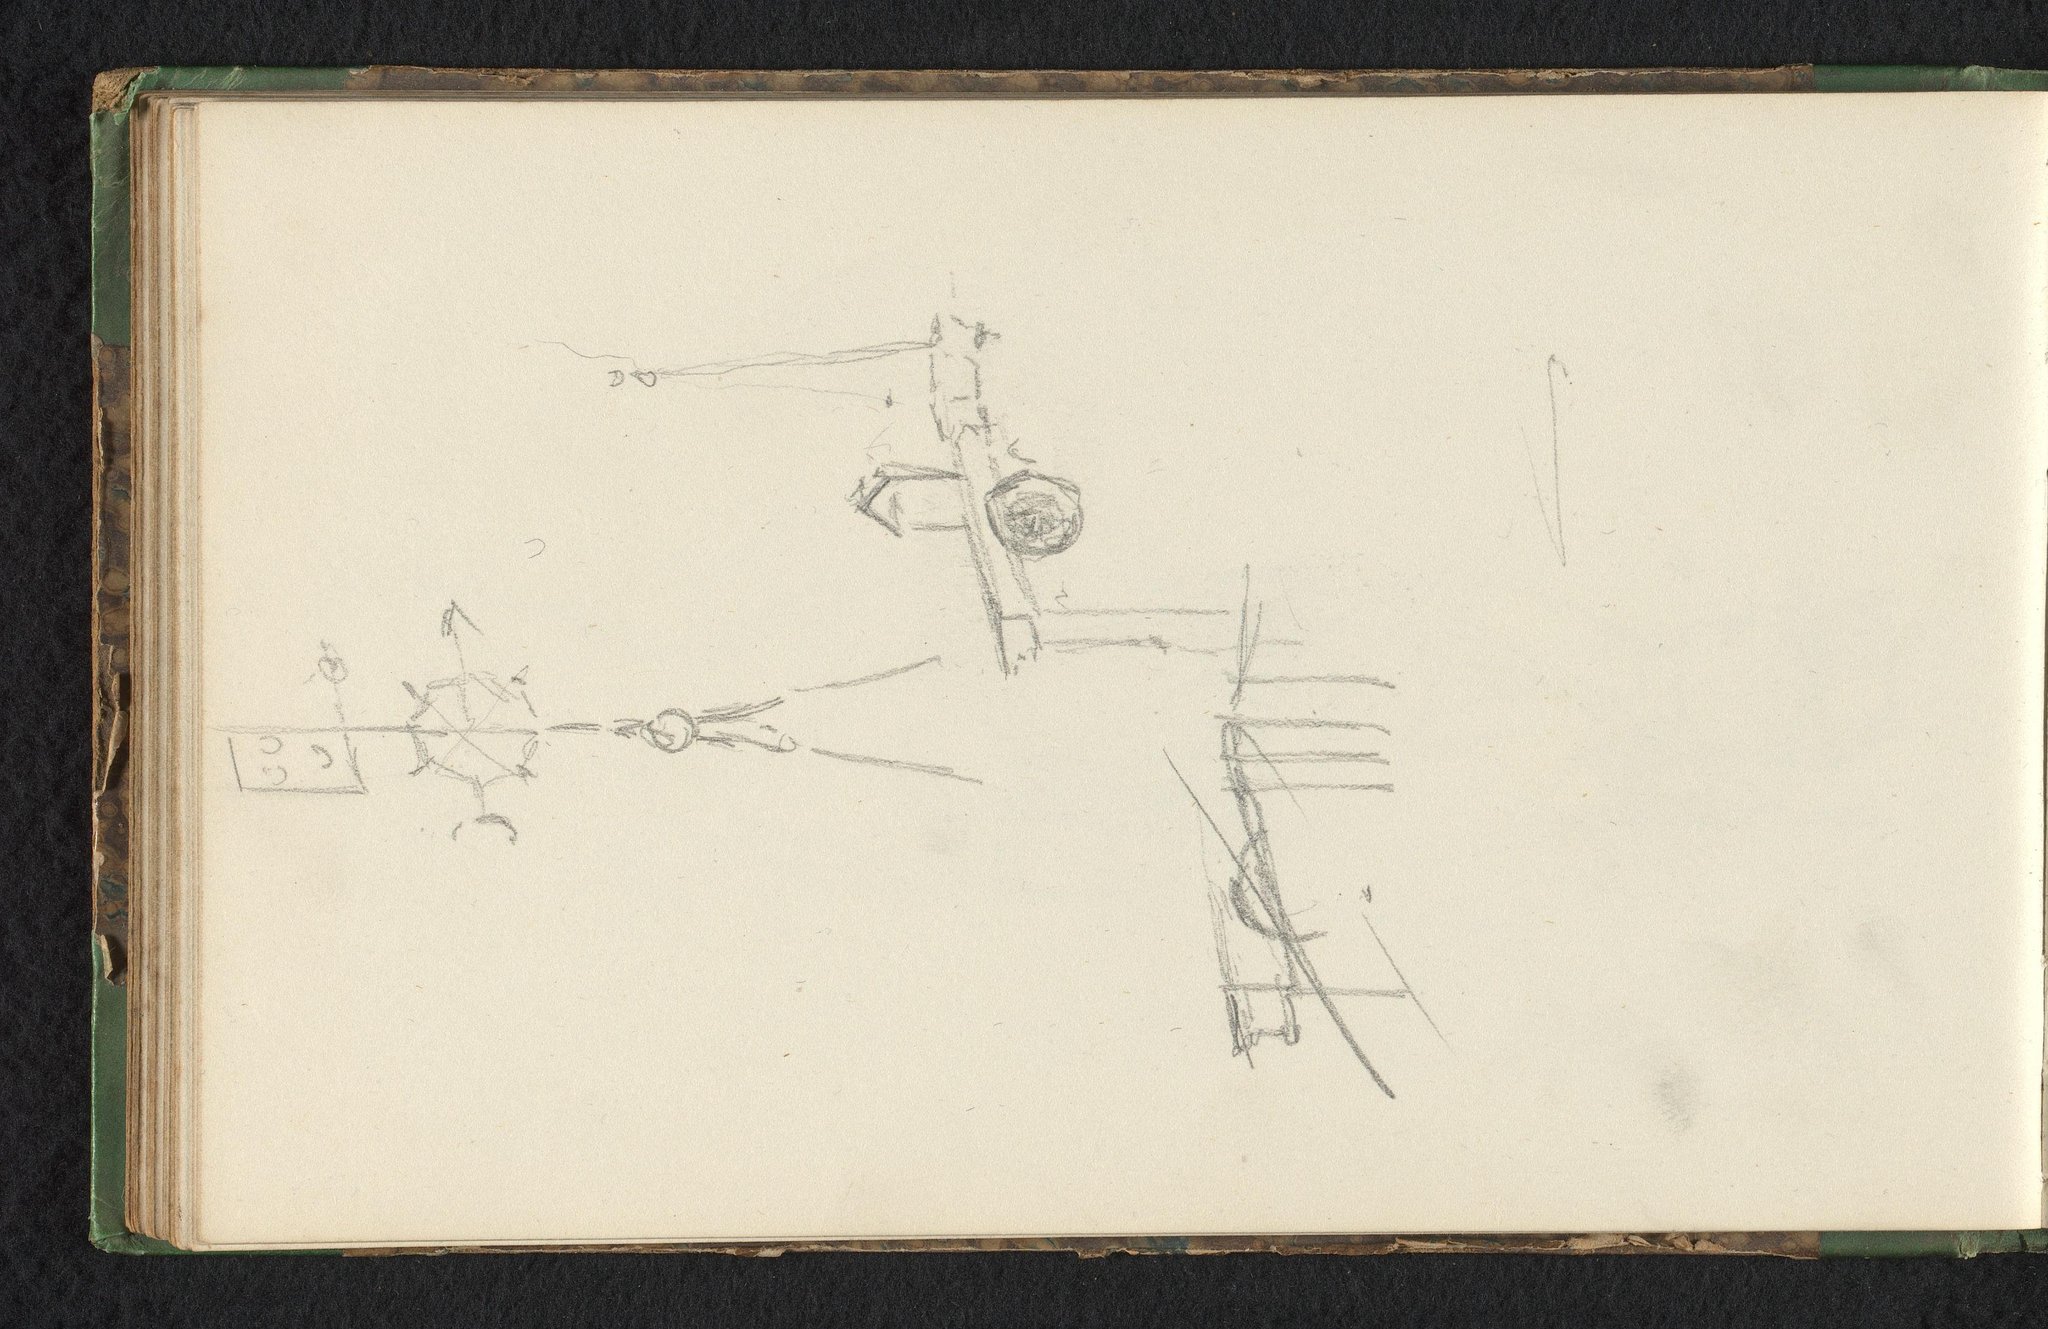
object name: sketchbook leaf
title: Blad met verscheidene delen van een kerk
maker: jan bedijs tom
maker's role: draughtsman, painter, print maker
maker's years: 1813-1894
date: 1823-1894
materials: paper, pencil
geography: the hague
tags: parts of church exterior and annexes: façade, parts of church exterior and annexes: tower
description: Pagina 21 verso uit een schetsboek met 61 bladen.